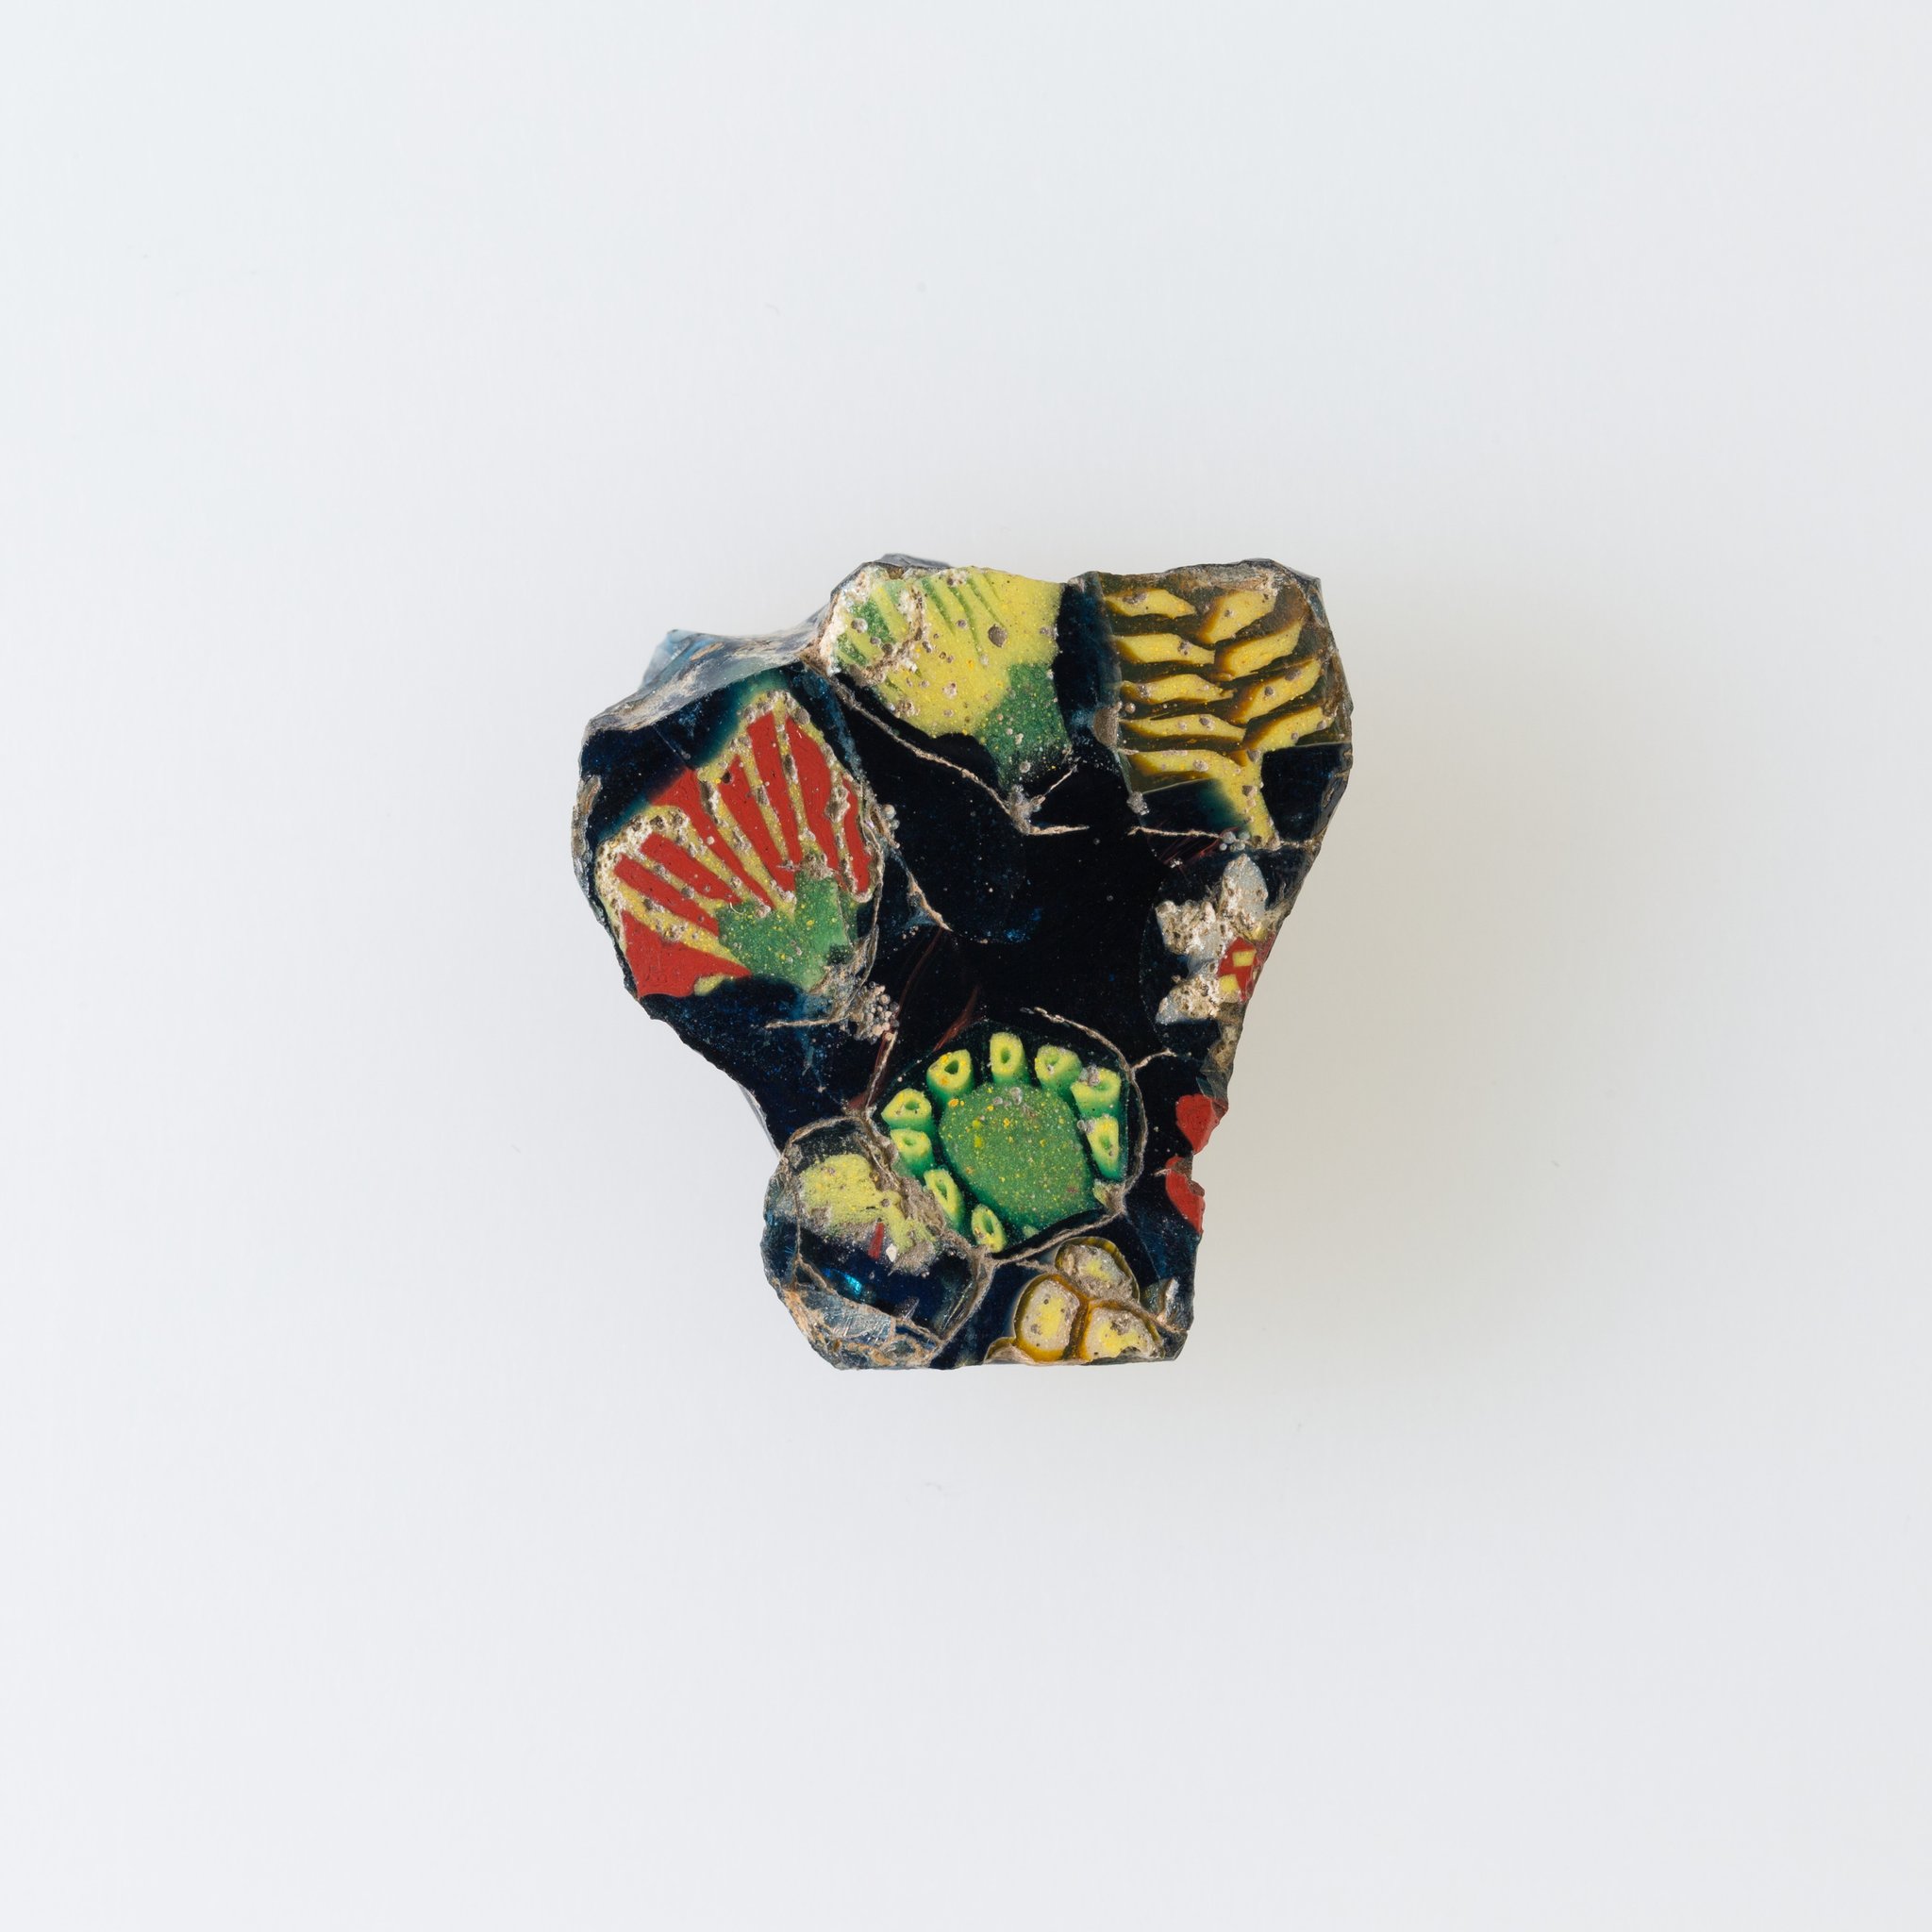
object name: plaque, floral, inlay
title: Floral plaque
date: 100 BCE-100 CE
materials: glass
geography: egypt